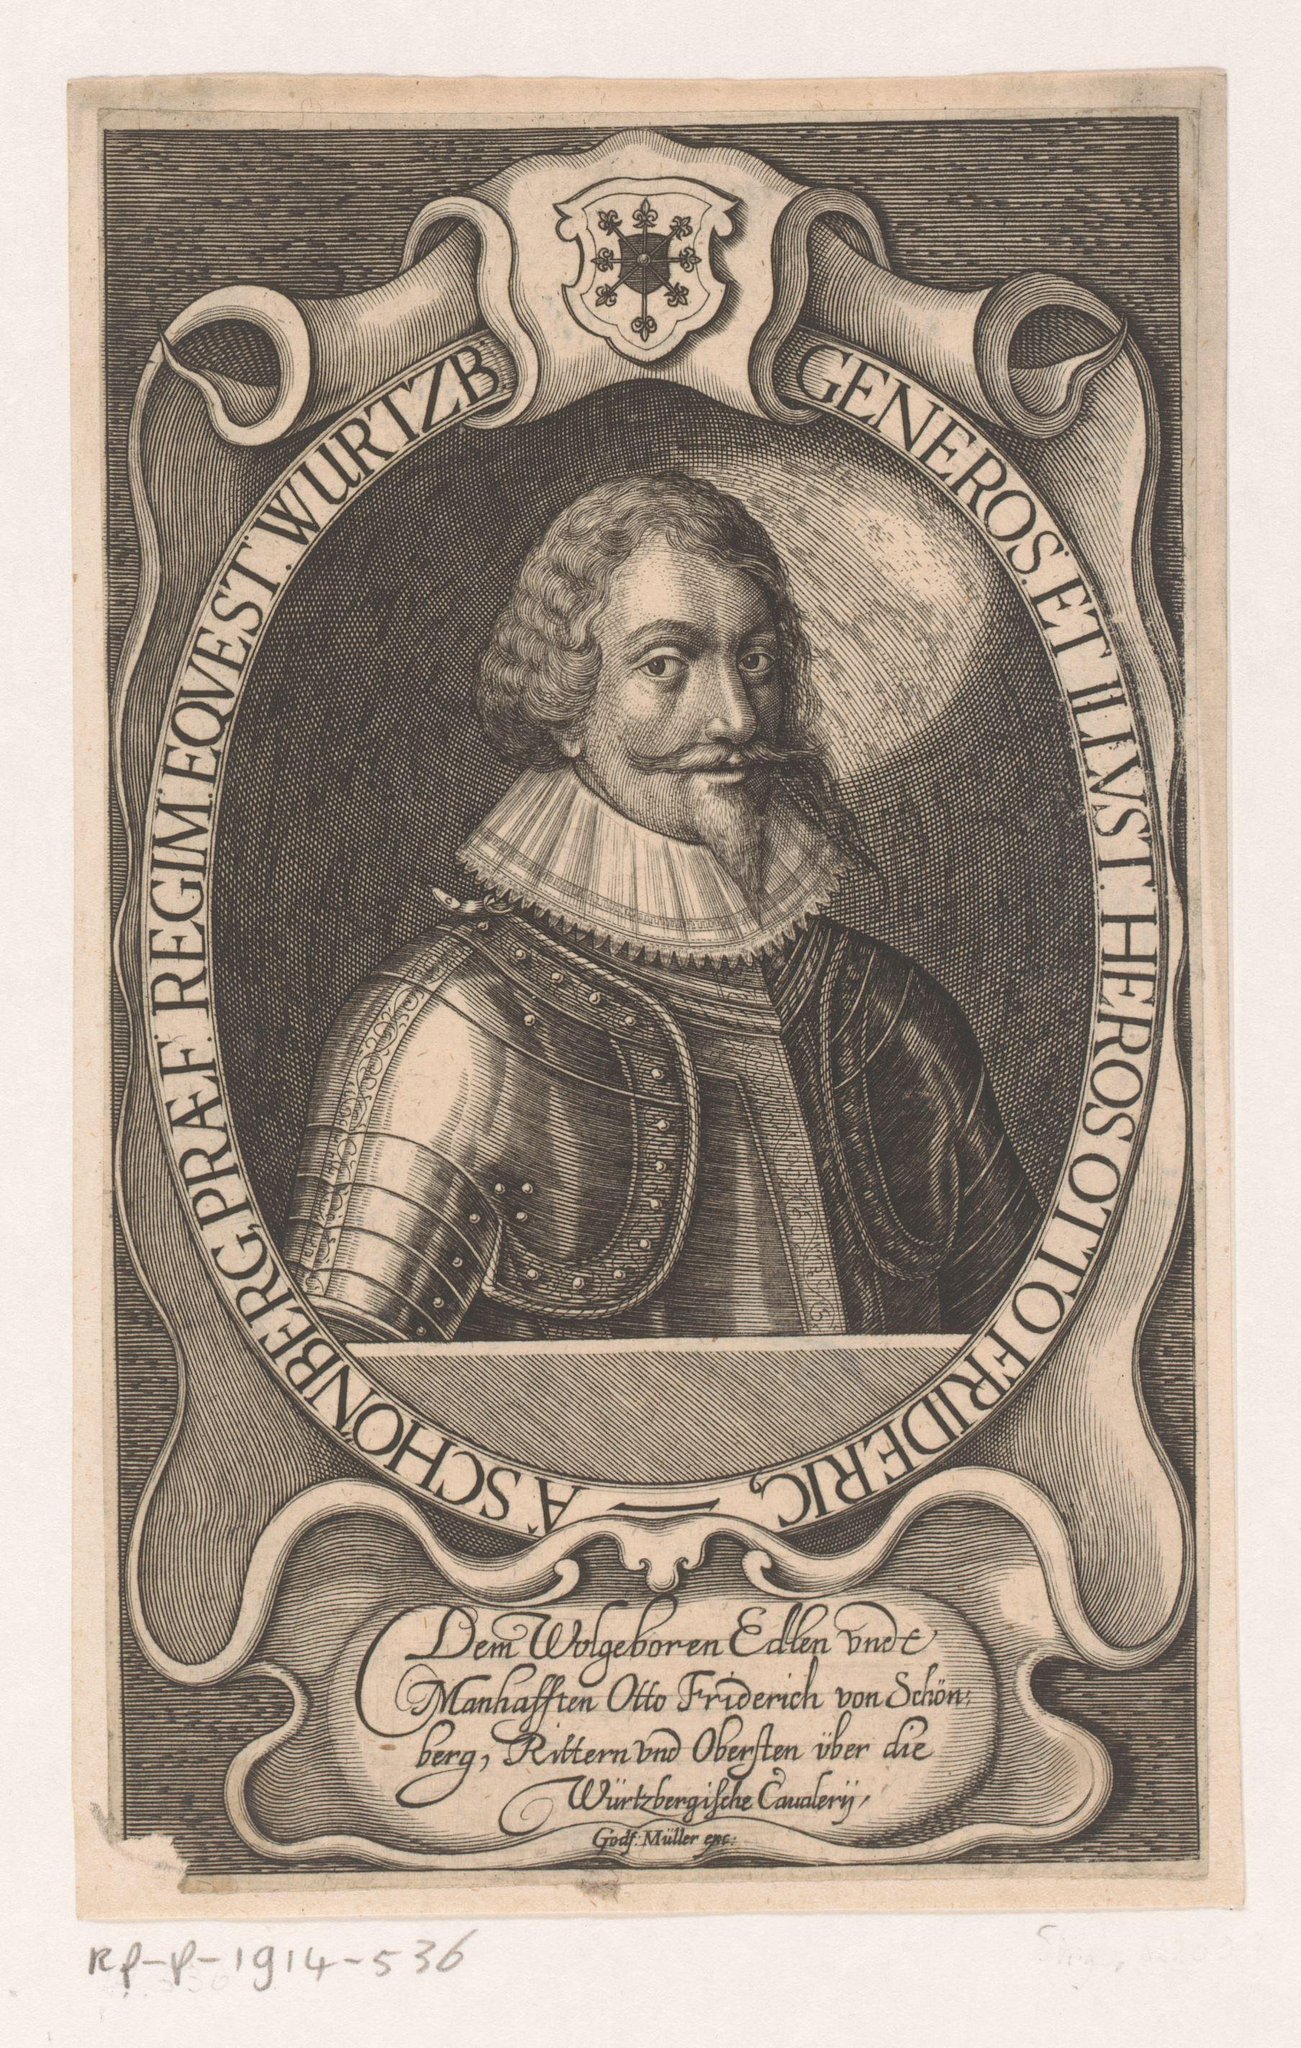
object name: print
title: Portret van Otto Friedrich Schönberg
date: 1620-1656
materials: paper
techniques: engraving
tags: armour, historical persons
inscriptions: collector's mark: Lugt 2228